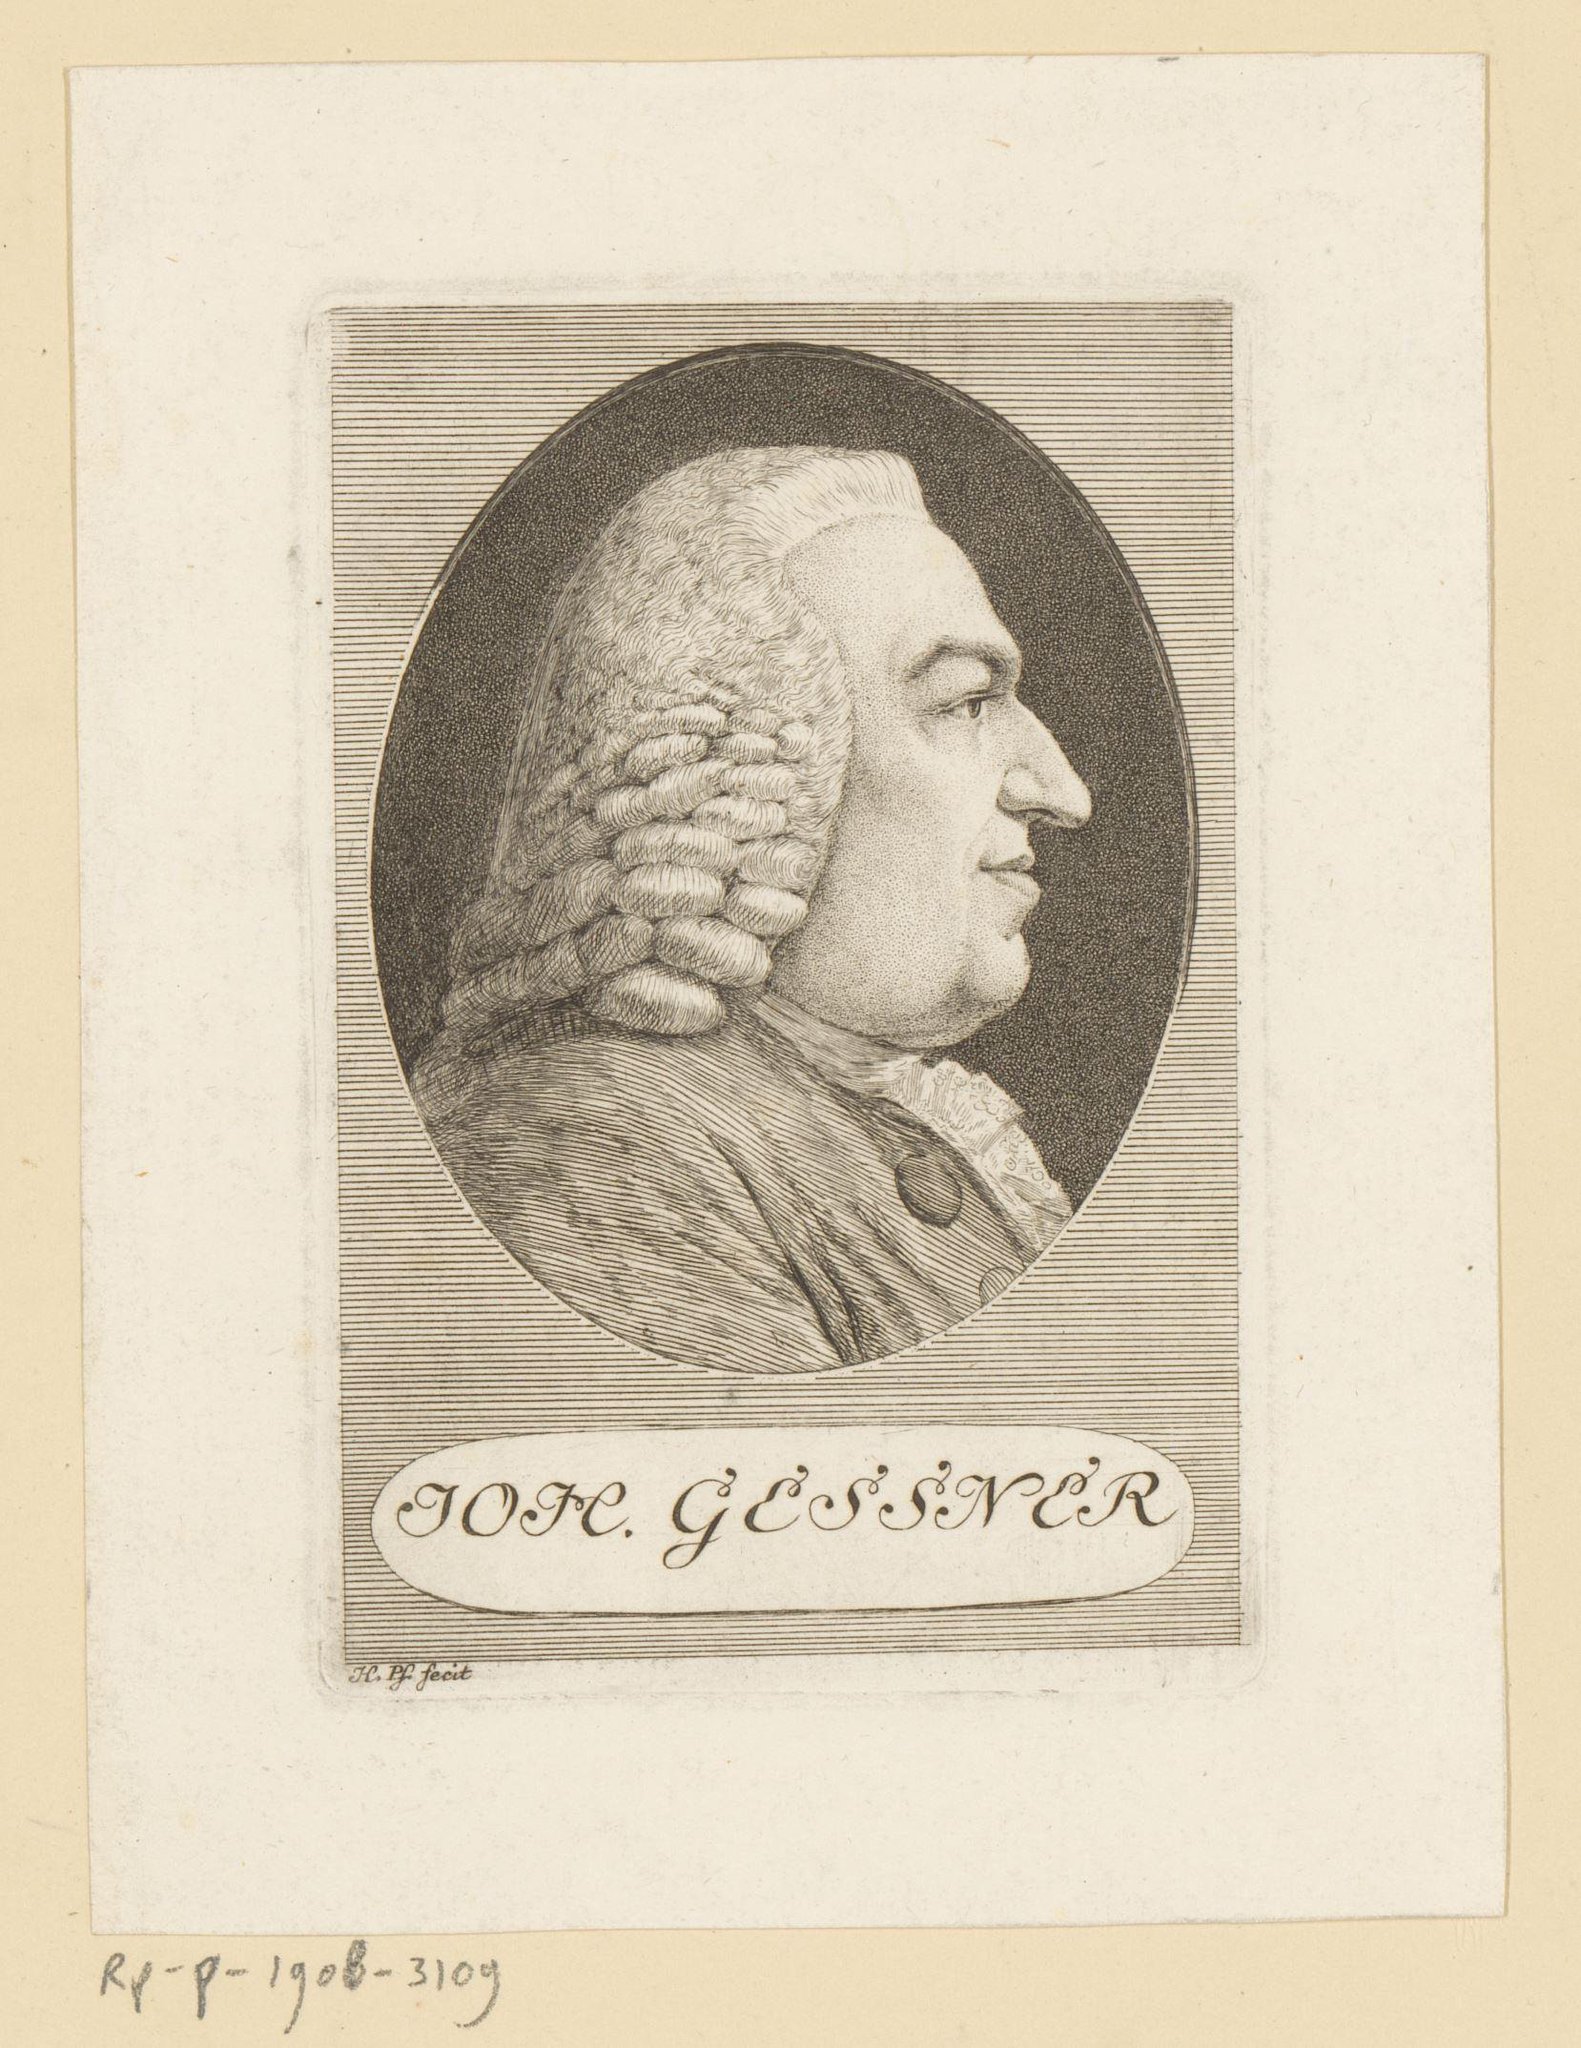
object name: print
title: Portret van Johann Georg Gessner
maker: heinrich pfenninger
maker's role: print maker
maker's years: 1749-1815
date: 1759-1815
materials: paper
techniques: etching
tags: johann georg gessner, historical persons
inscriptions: collector's mark: Lugt 2228